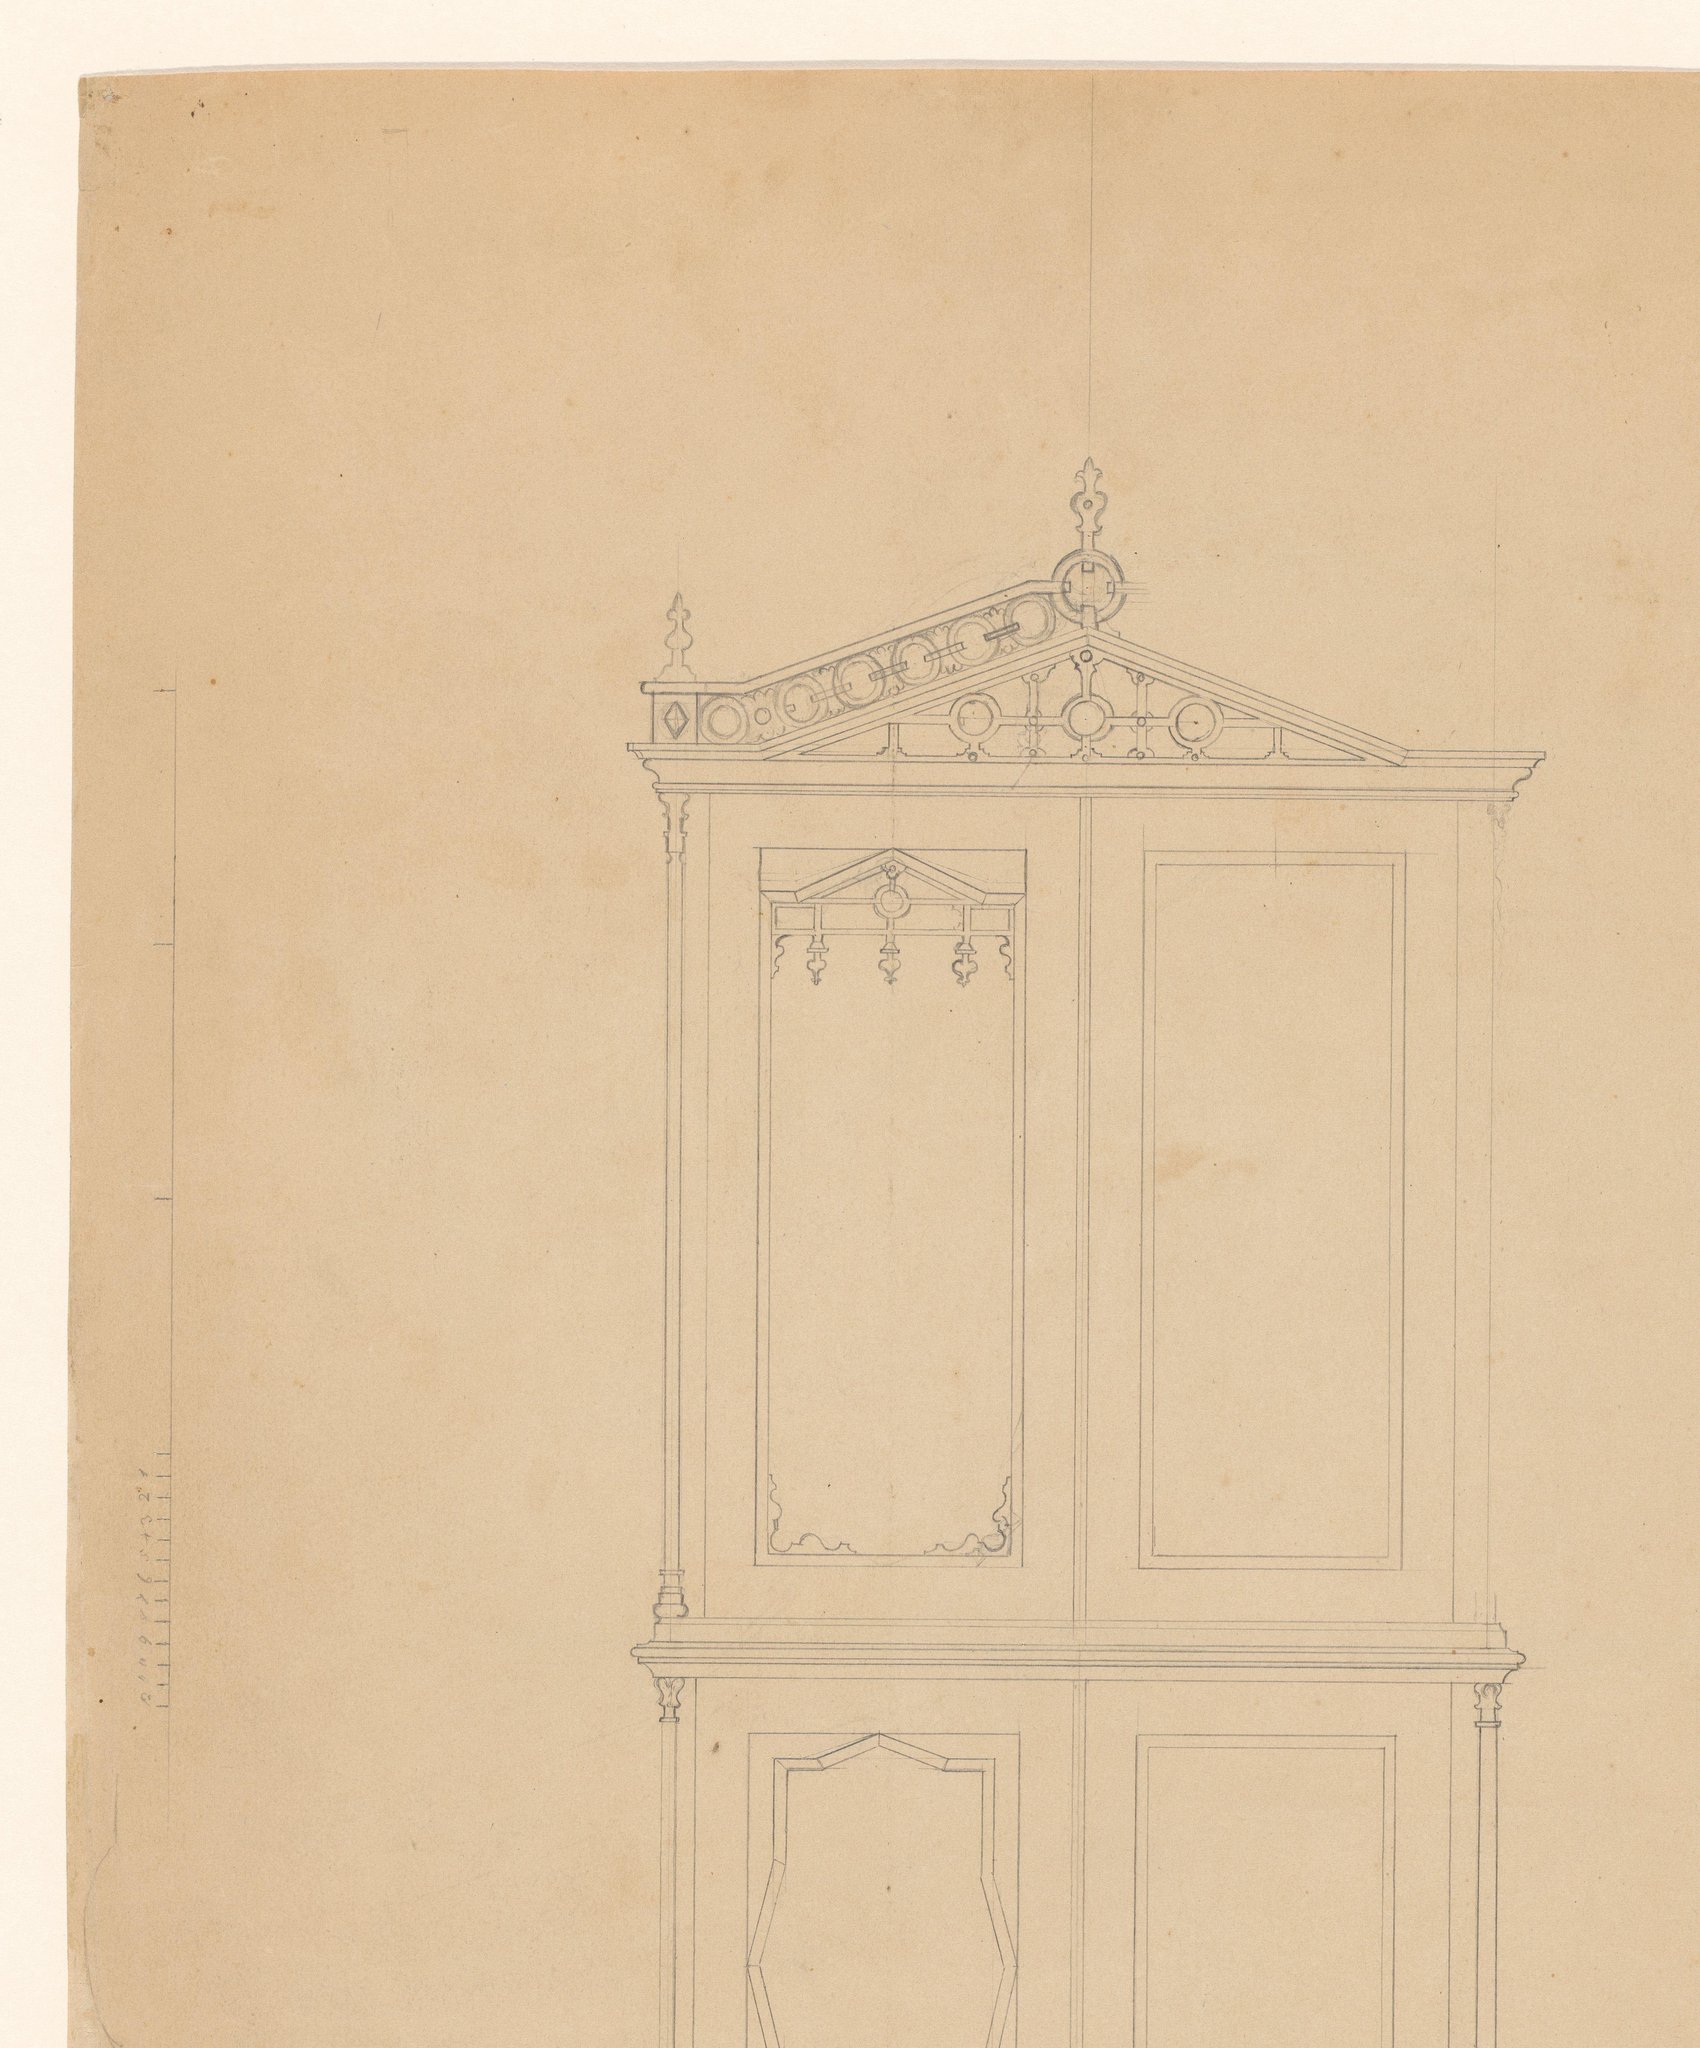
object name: drawing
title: Ontwerp voor een vierdeurskast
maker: joseph kusterer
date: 1865-1870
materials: graphite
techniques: drawing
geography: mainz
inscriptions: size: ‘Maatverdeling met 12 11 10 9 8 7 6 5 4 3 2 1’